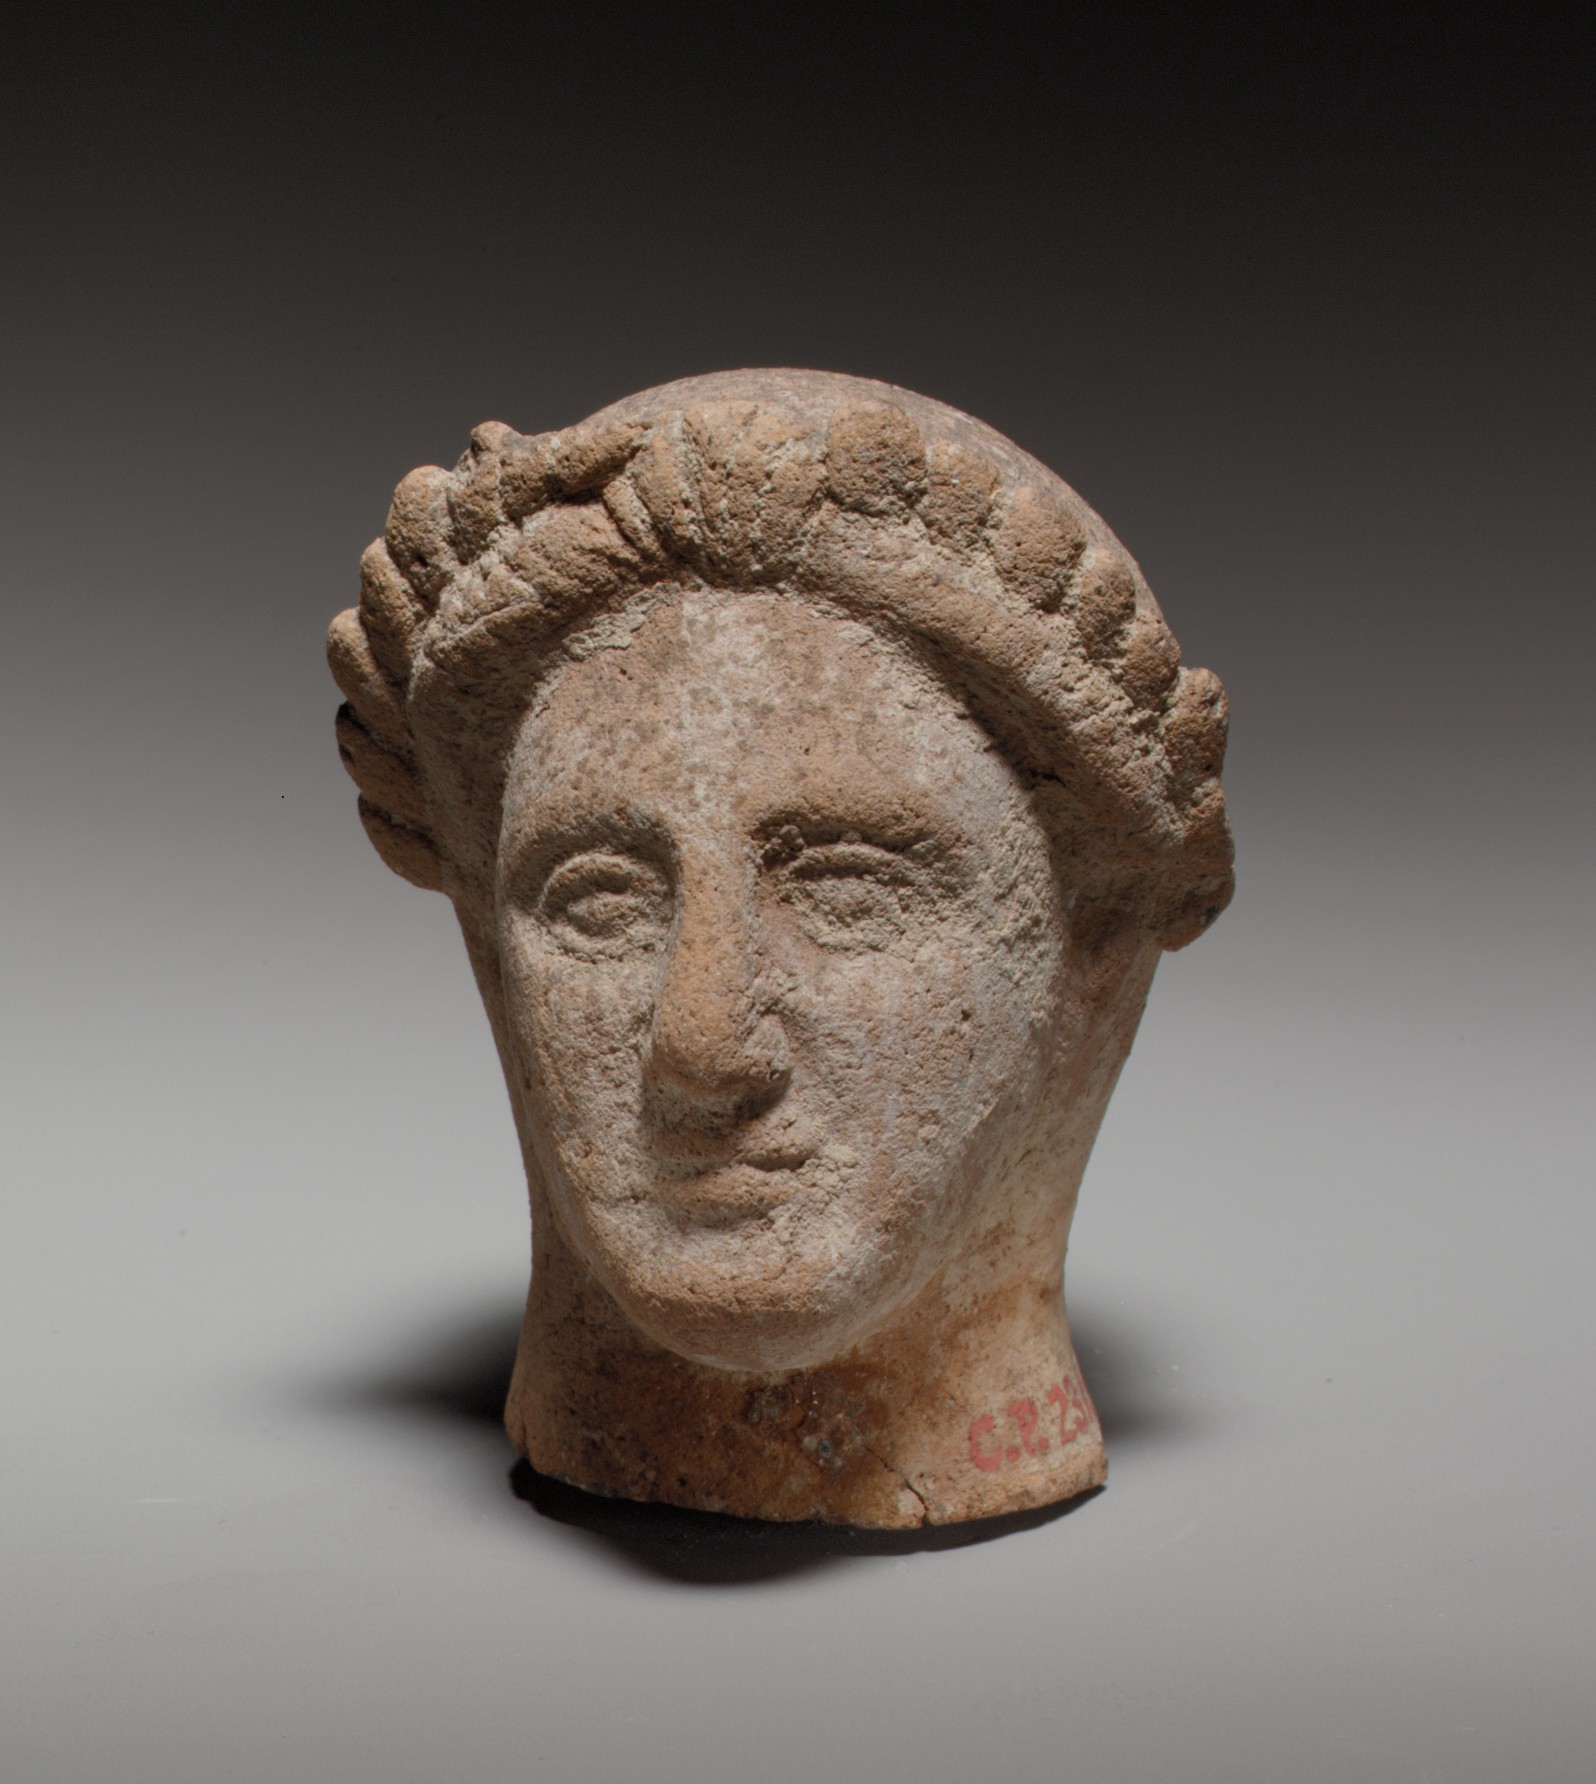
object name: head of a deity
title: Terracotta male head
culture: cypriot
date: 400-301 BCE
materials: terracotta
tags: heads,men